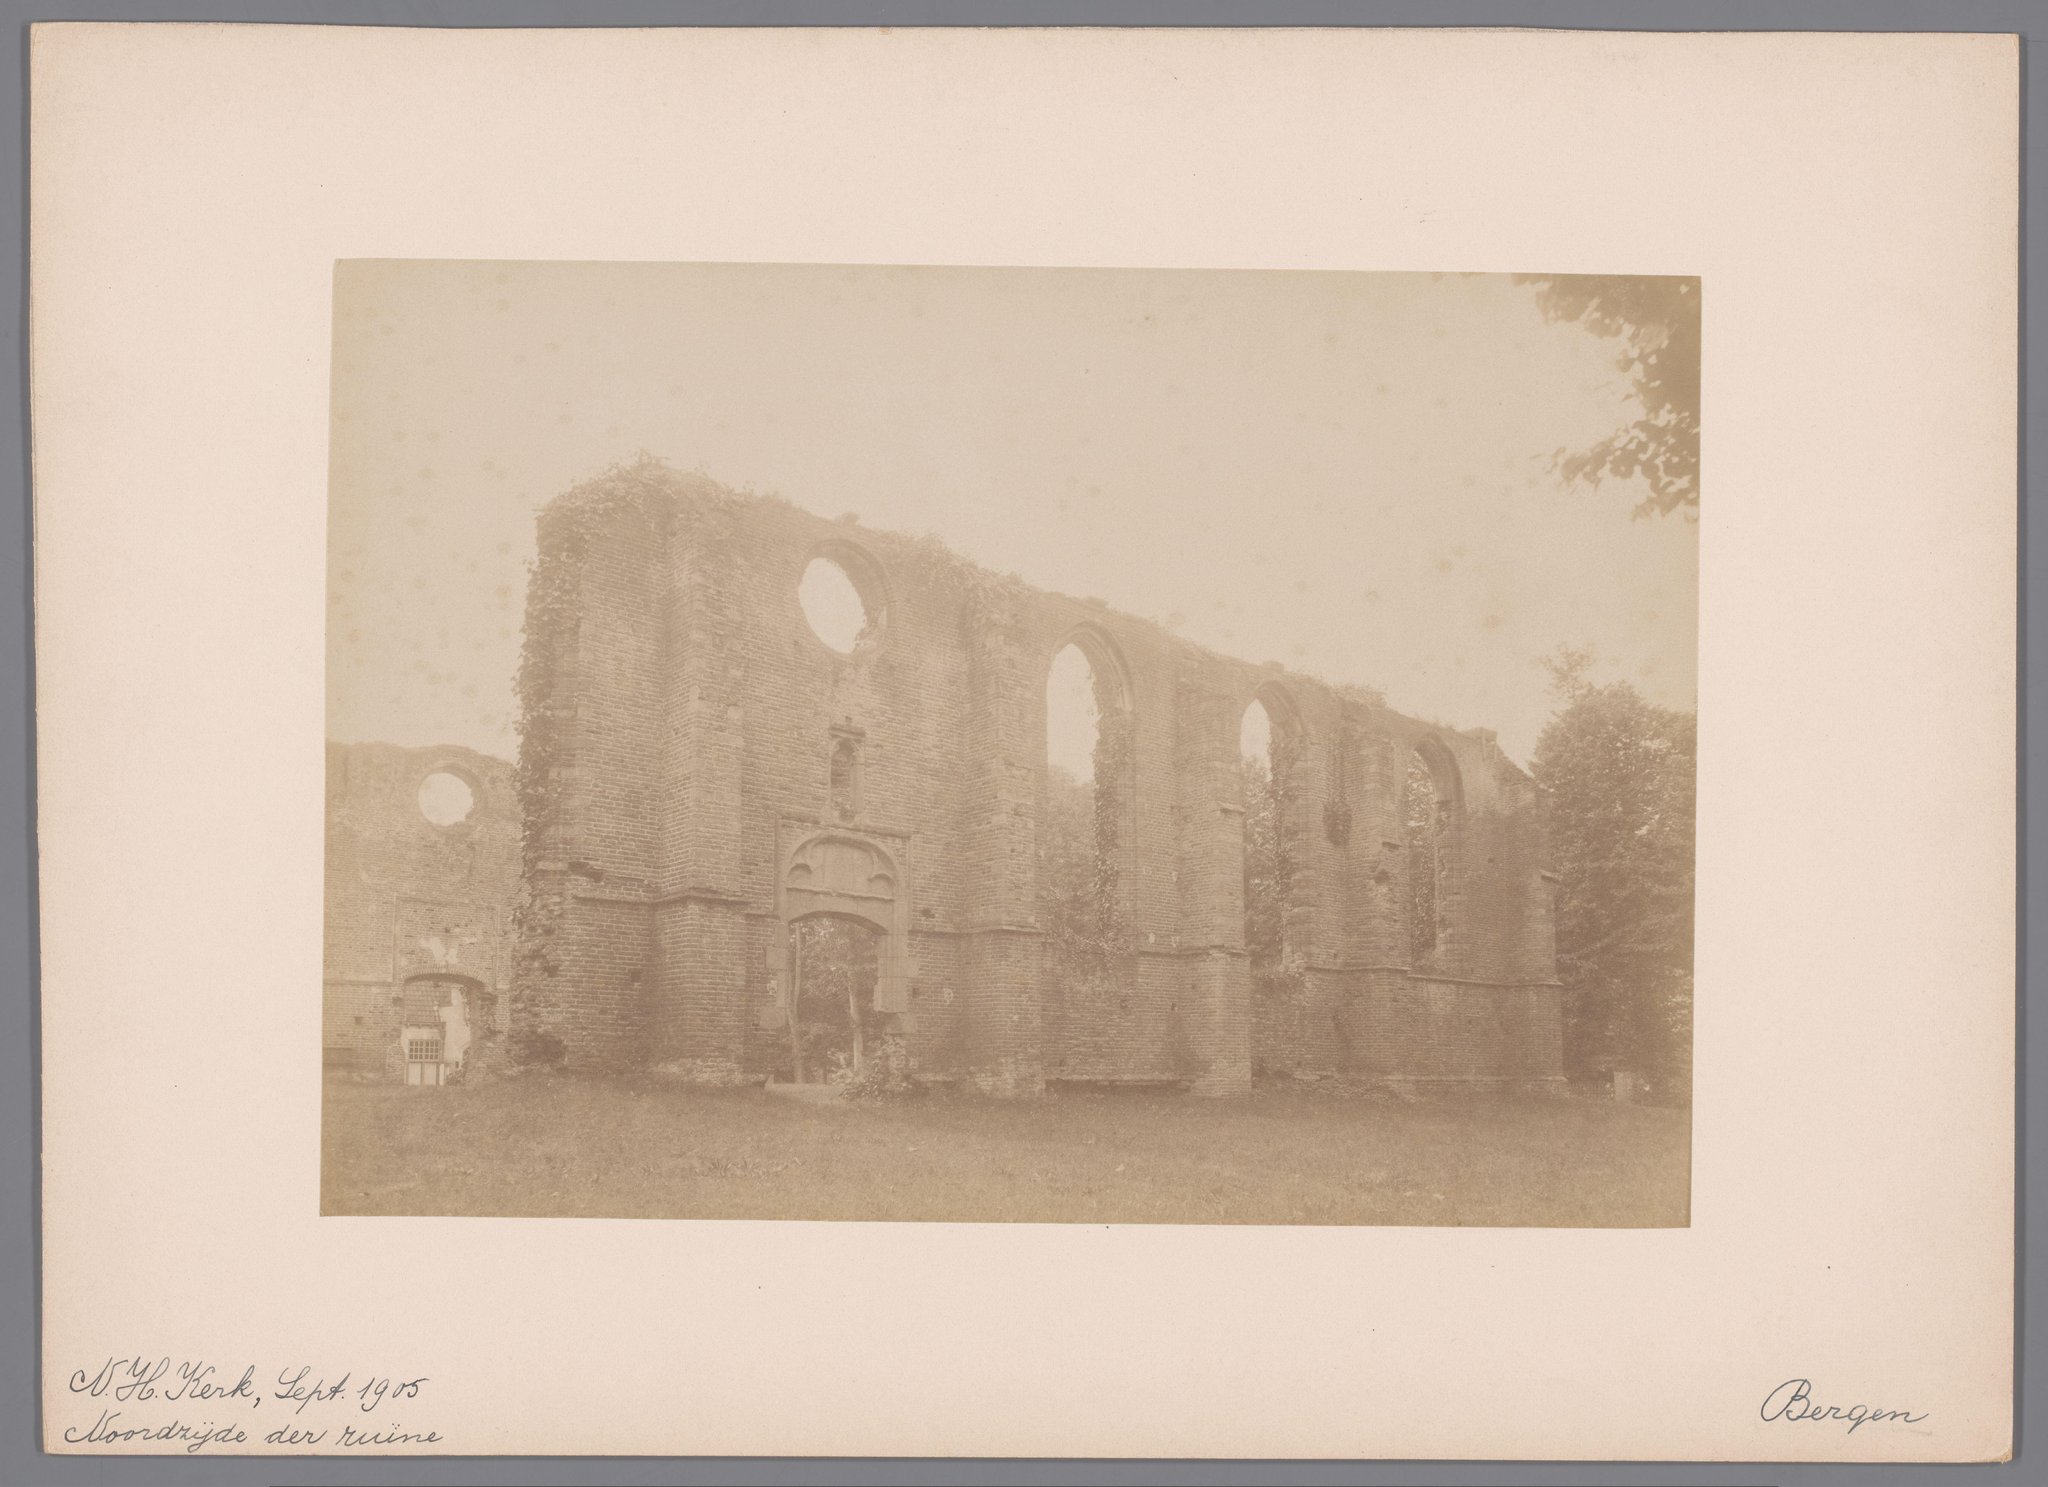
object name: photograph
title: Muur van de Ruïnekerk te Bergen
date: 1905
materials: cardboard, photographic support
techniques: albumen print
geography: bergen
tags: church (exterior), ruin of church, monastery, etc.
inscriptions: annotation: ‘N.H. Kerk, sept. 1905/ Noordzijde der ruïne/ Bergen’, annotation: ‘Bergen N.H./ Noordzijde der ruïne/ sept 1905’